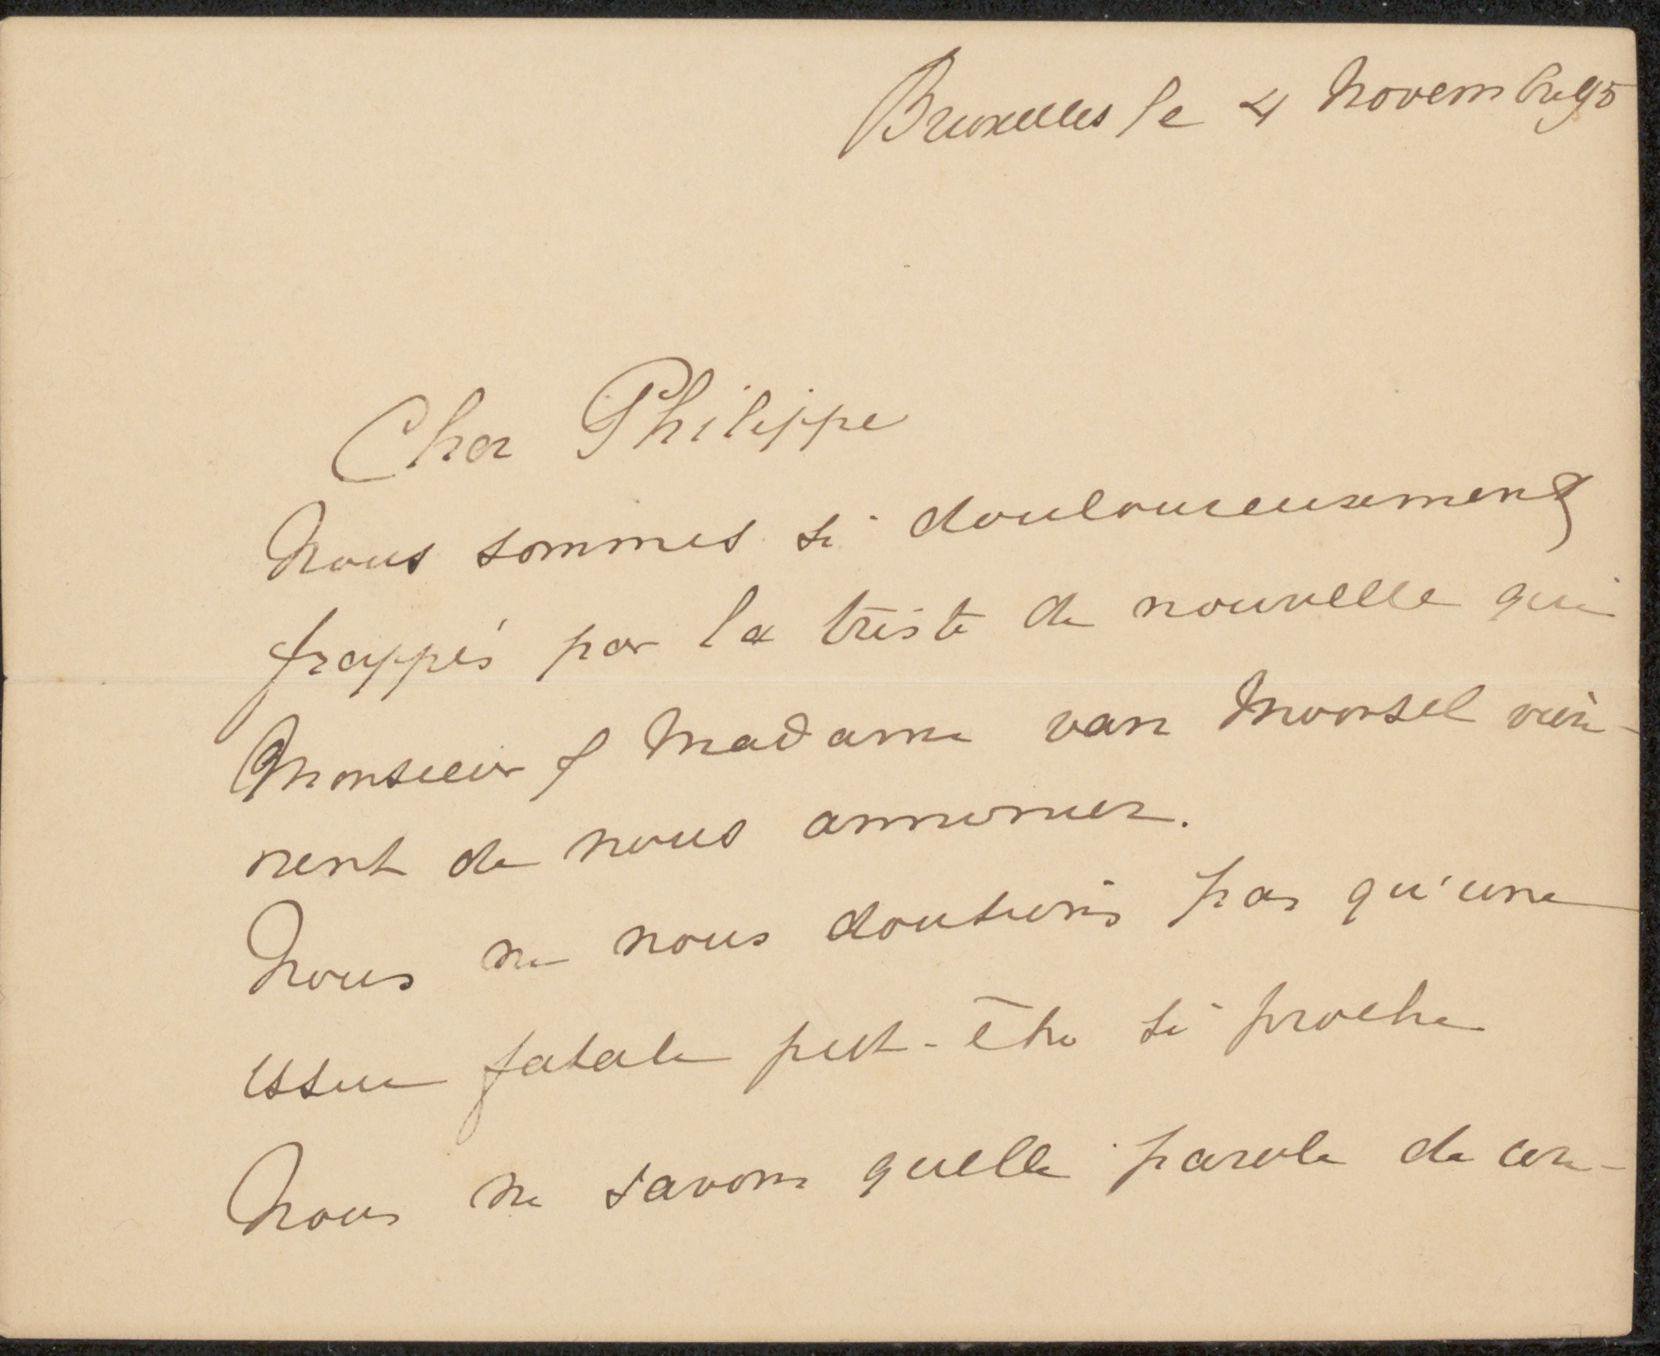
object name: letter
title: Brief aan Philip Zilcken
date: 1895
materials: cardboard, ink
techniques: pen, writing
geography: brussels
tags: brussels, helène lambertine hauzeur, the hague, painter, draughtsman, philip zilcken, passions, emotions, affections